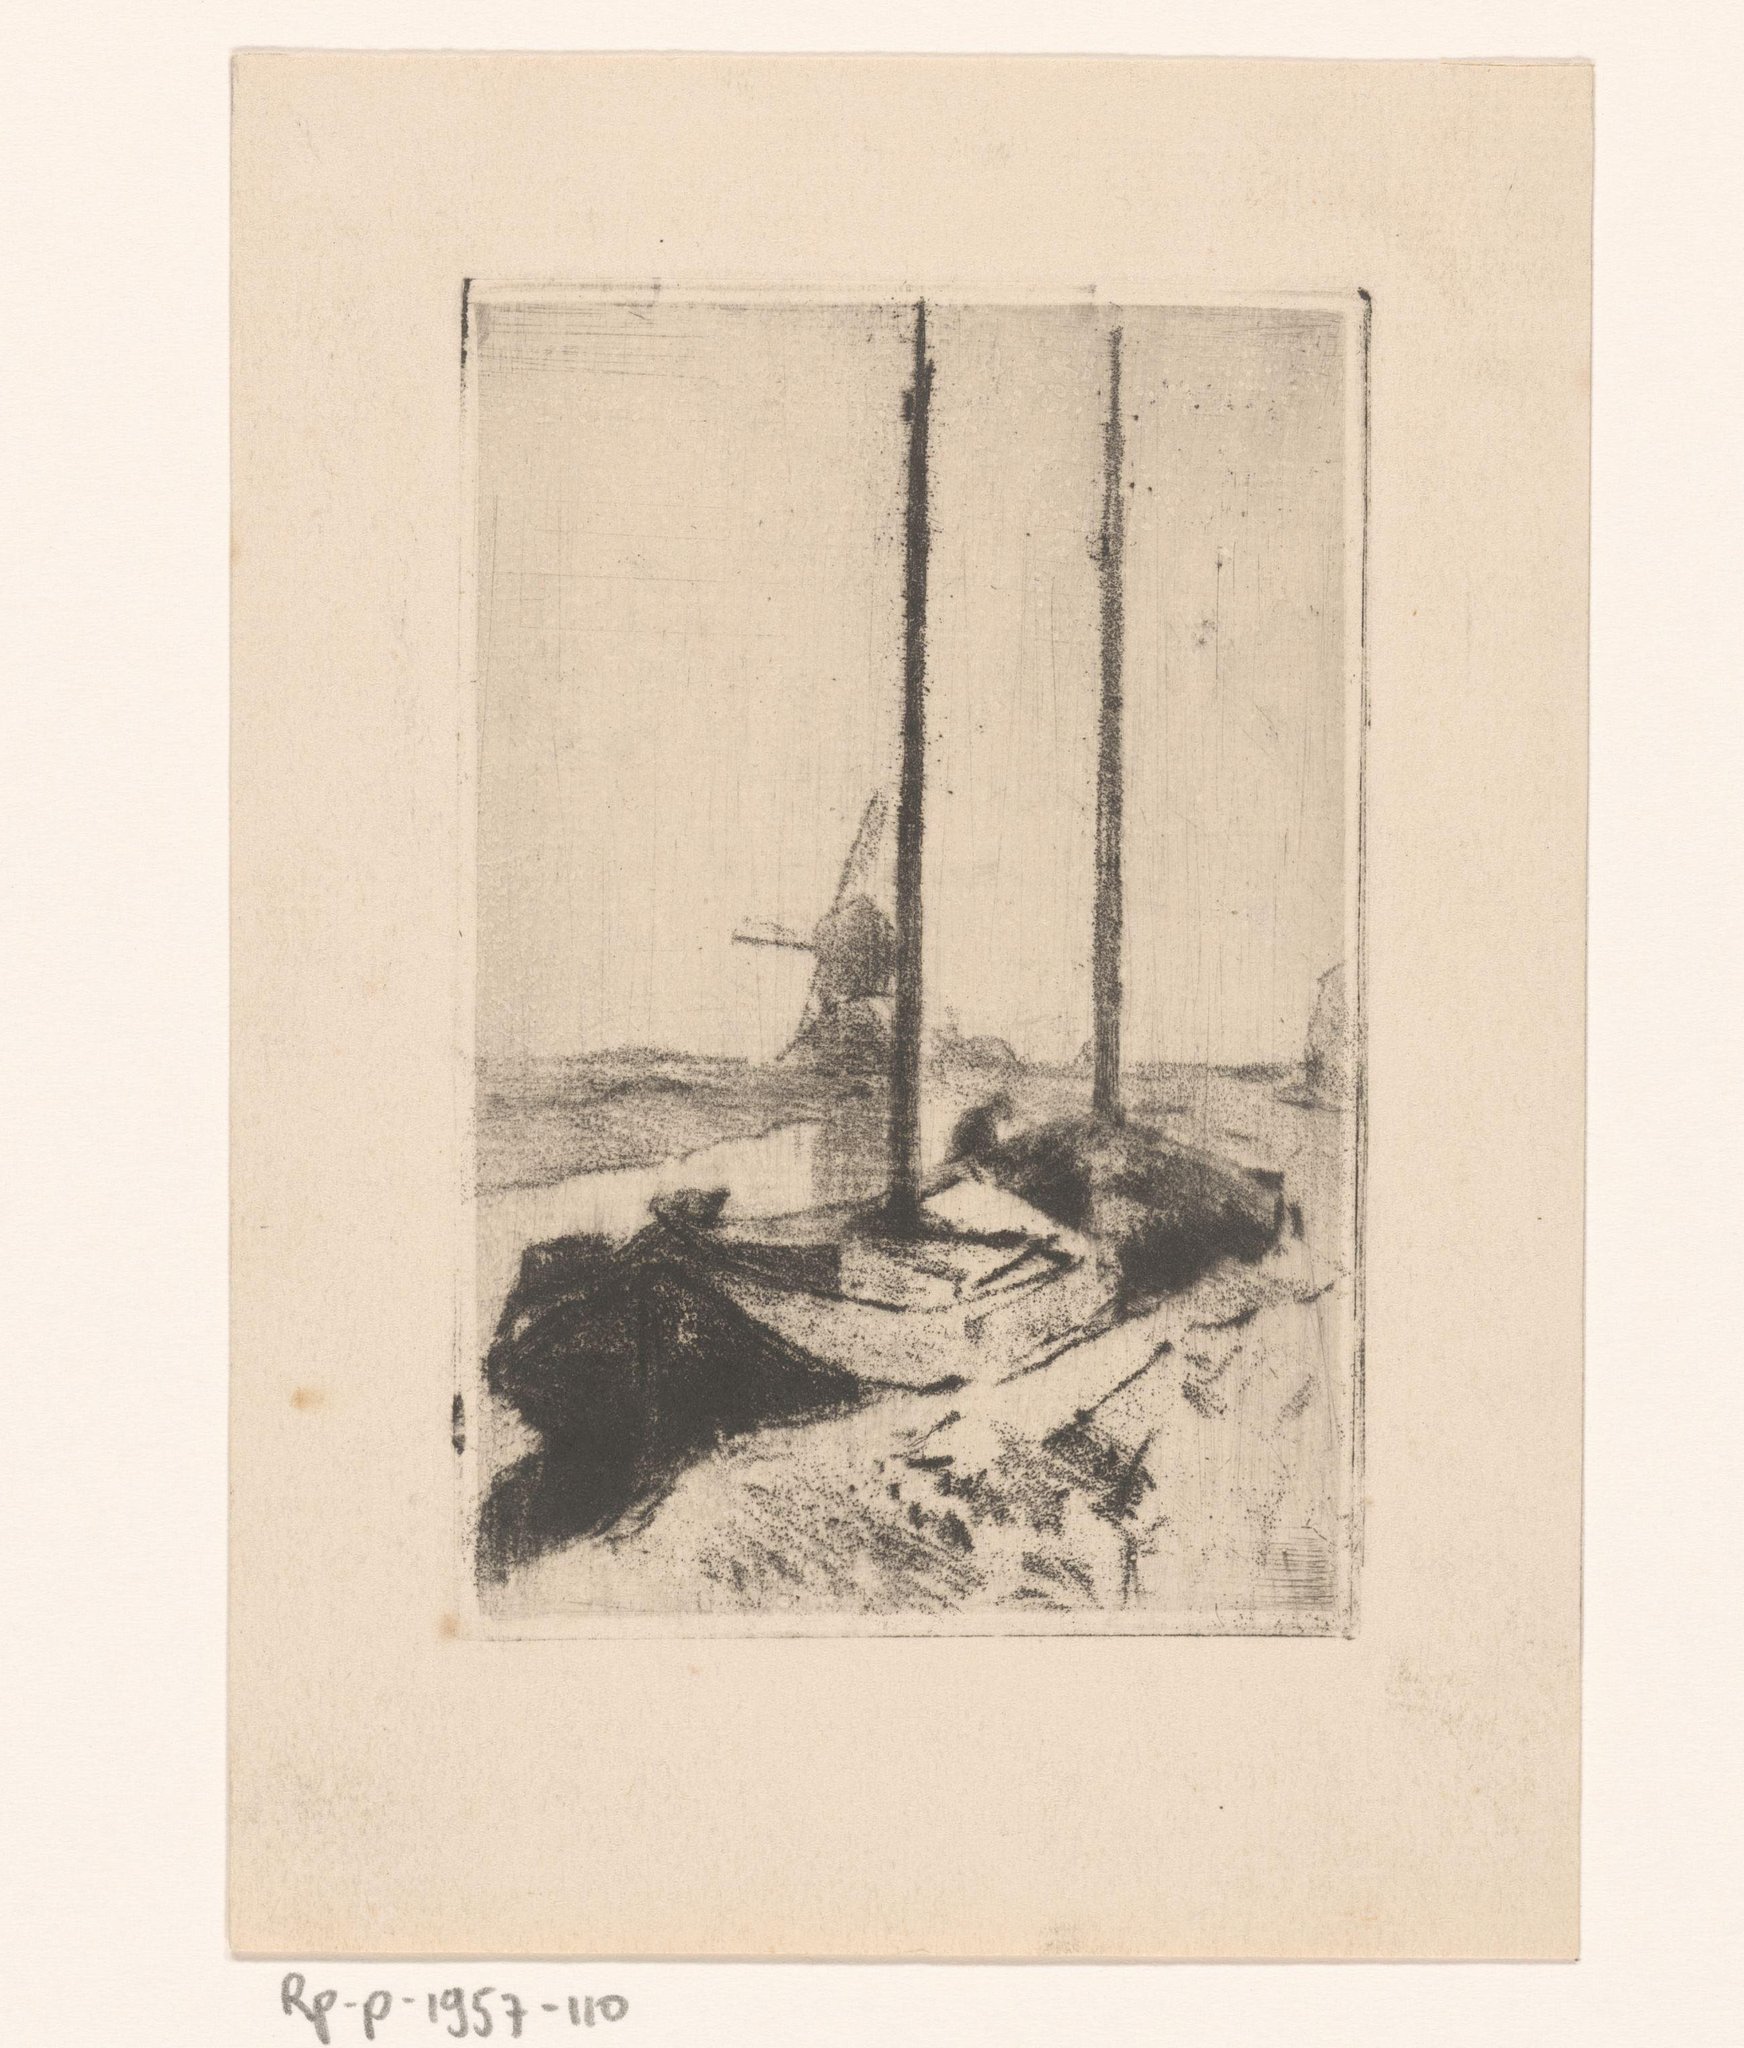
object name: print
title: Twee schepen in een vaart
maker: chris van der windt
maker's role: print maker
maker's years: 1877-1952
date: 1887-1952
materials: paper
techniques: soft ground etching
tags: boat propelled by man or animal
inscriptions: collector's mark: Lugt 2228